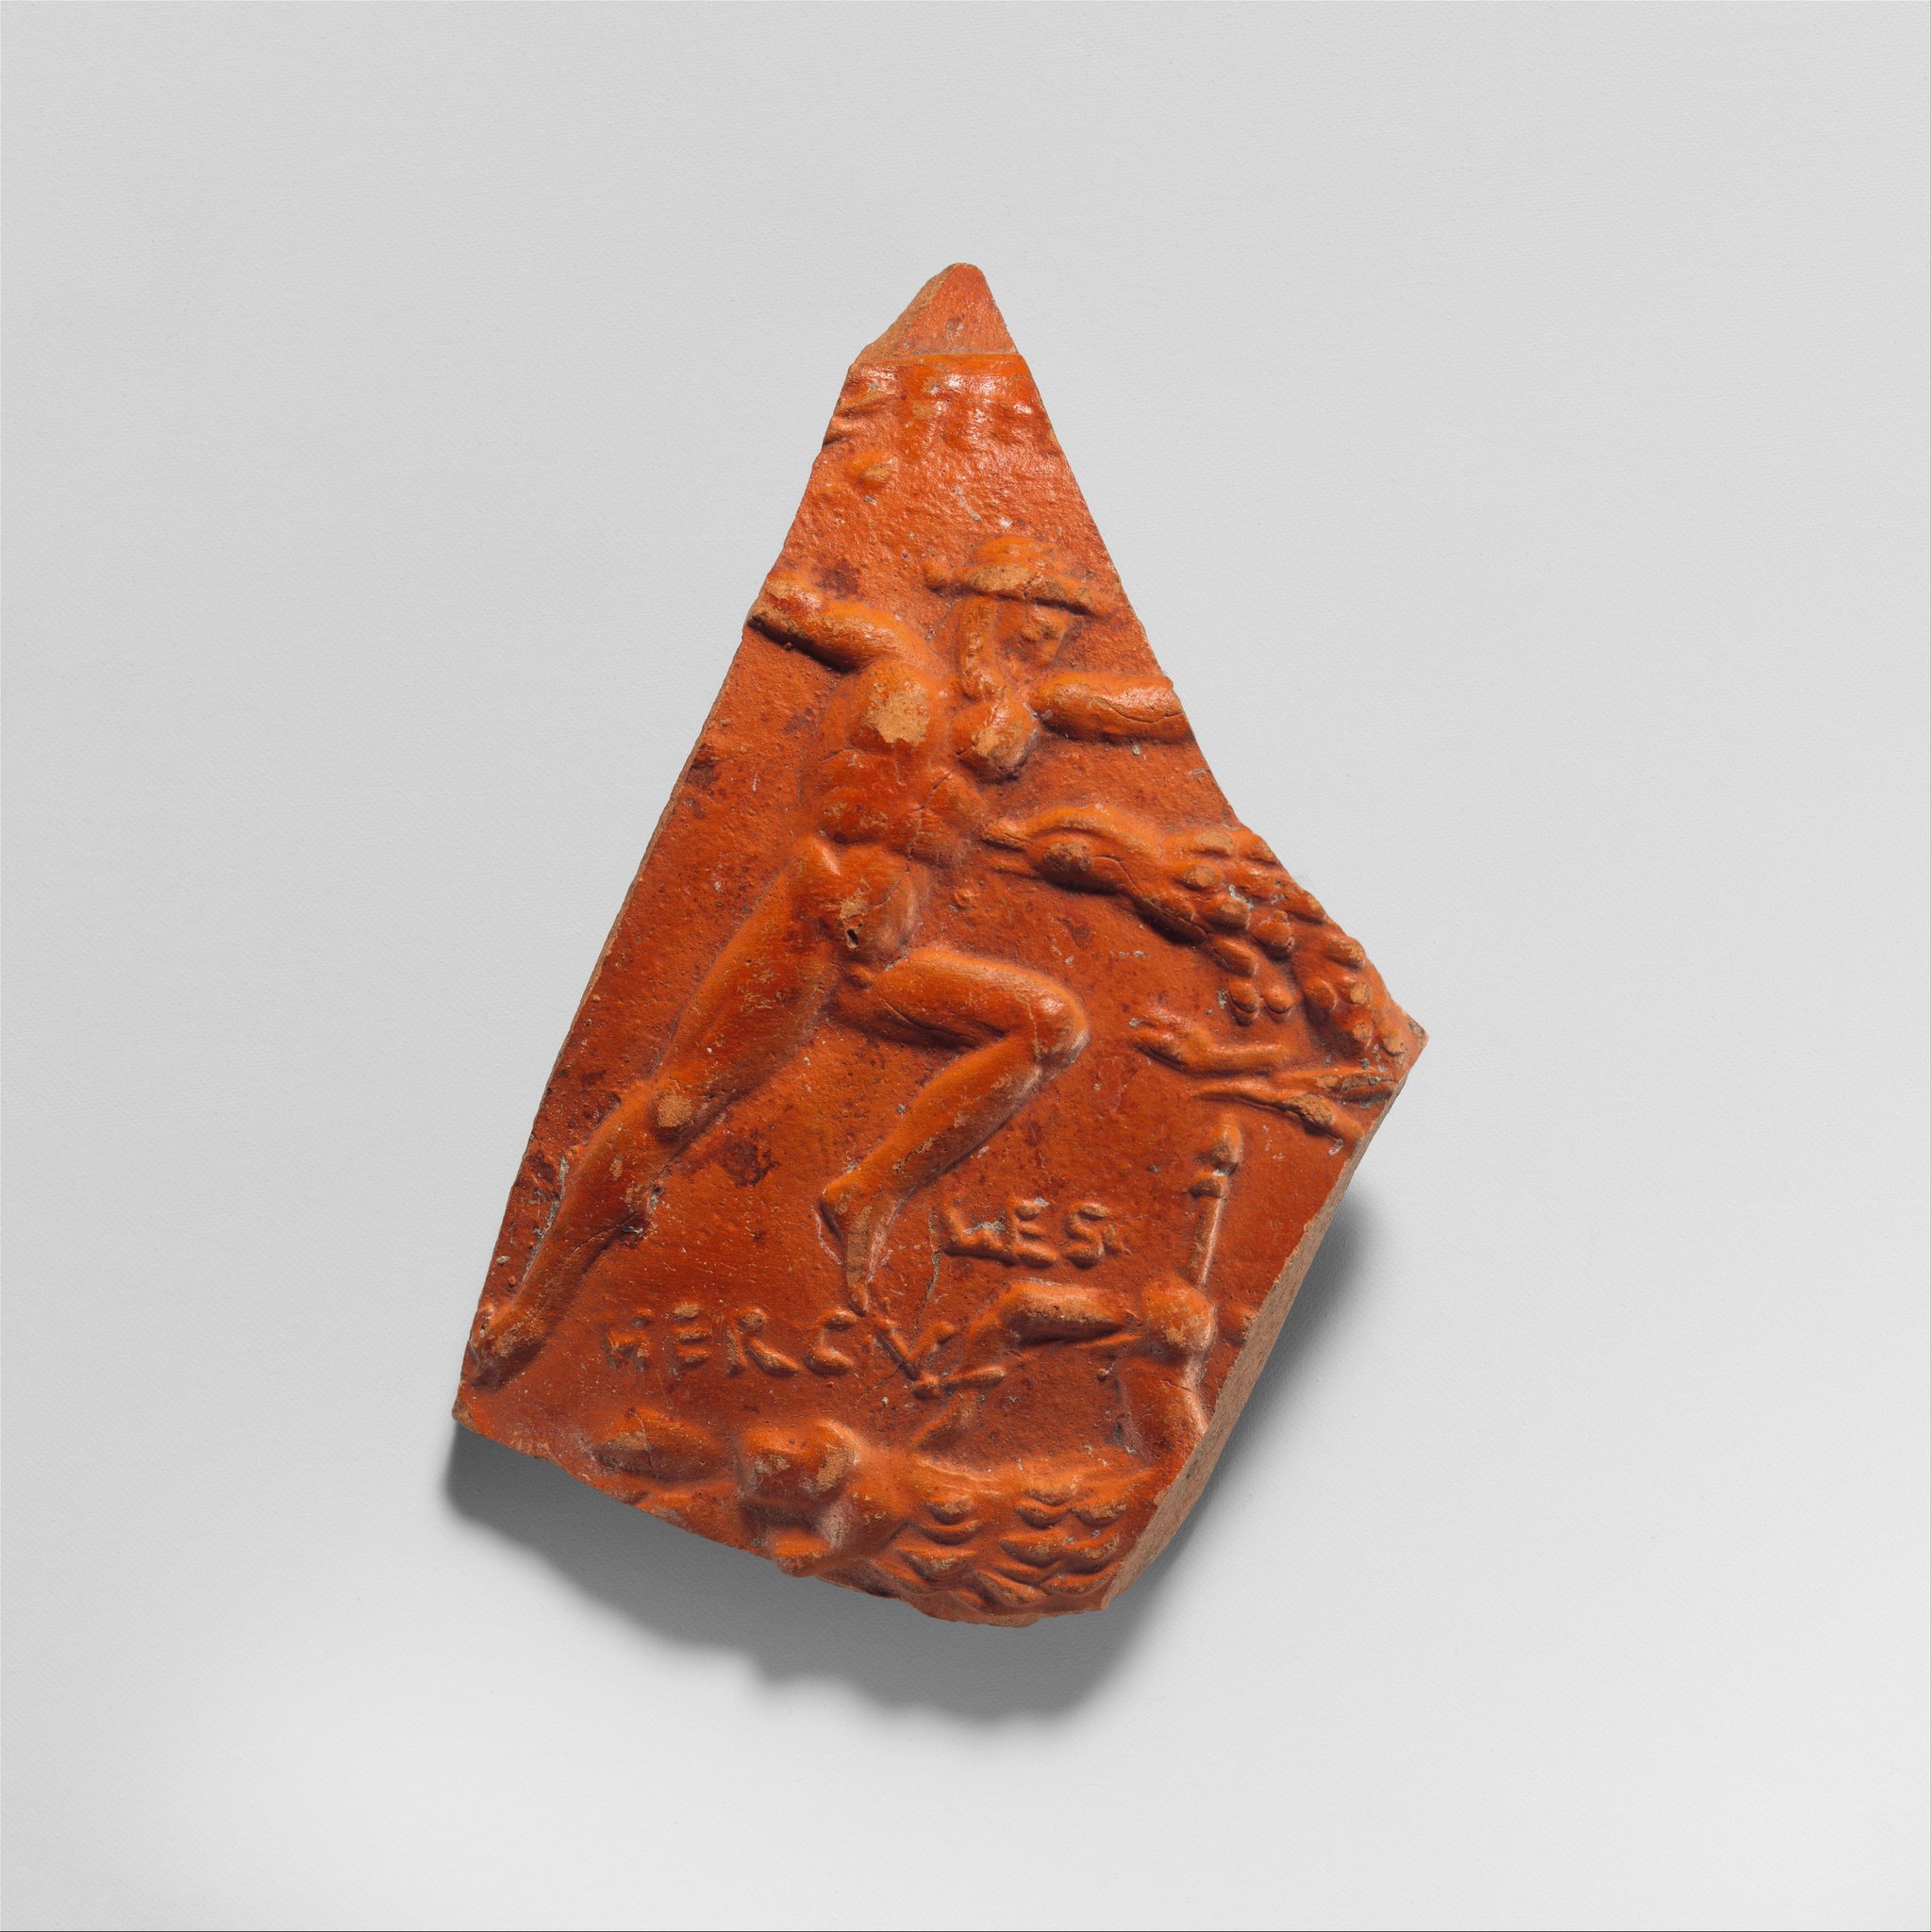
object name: vase fragment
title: Terracotta medallion fragment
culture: roman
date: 134-166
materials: terracotta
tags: eagles,herakles,prometheus